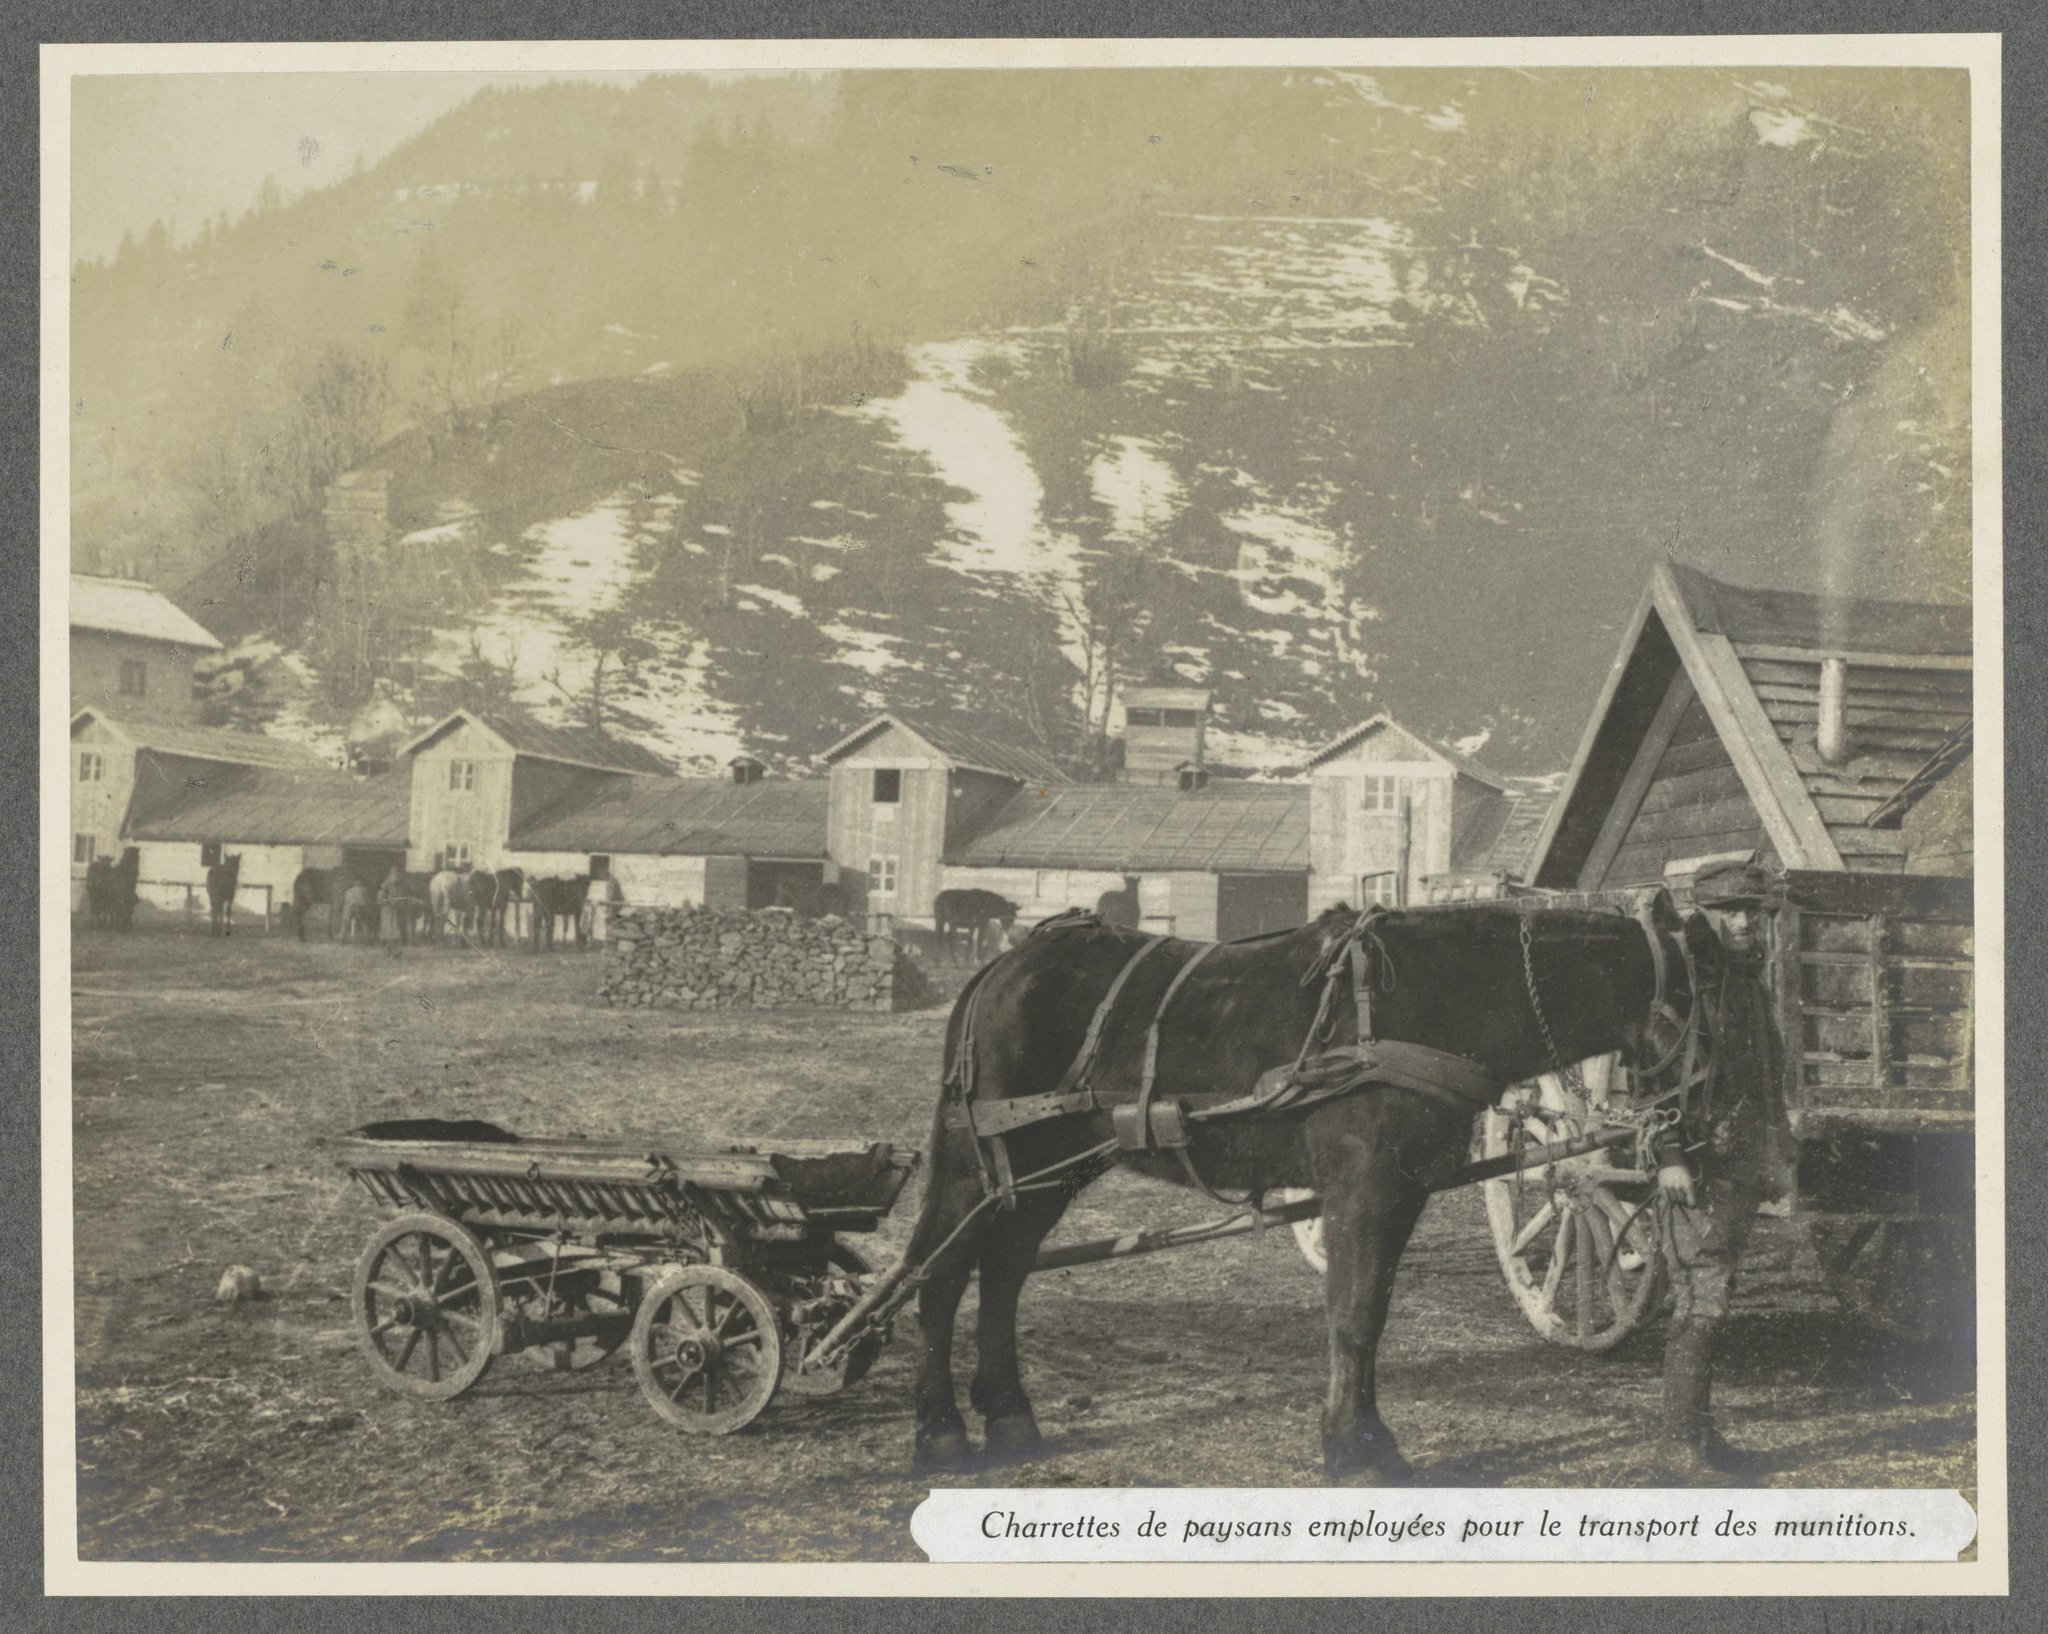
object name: photograph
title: Vermoedelijk Italiaanse militair vervoert munitie met een boerenkar in de Dolomieten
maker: henri de rothschild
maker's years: 1872-1947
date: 1916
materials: photographic support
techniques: gelatin silver print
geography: dolomites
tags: war (+ land forces), four-wheeled, animal-drawn vehicle, e.g.: cab, carriage, coach (+ conveyance for transport of persons)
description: Onderdeel van Fotoalbum Medische missie H. de Rothschild naar het Italiaanse front 1916.